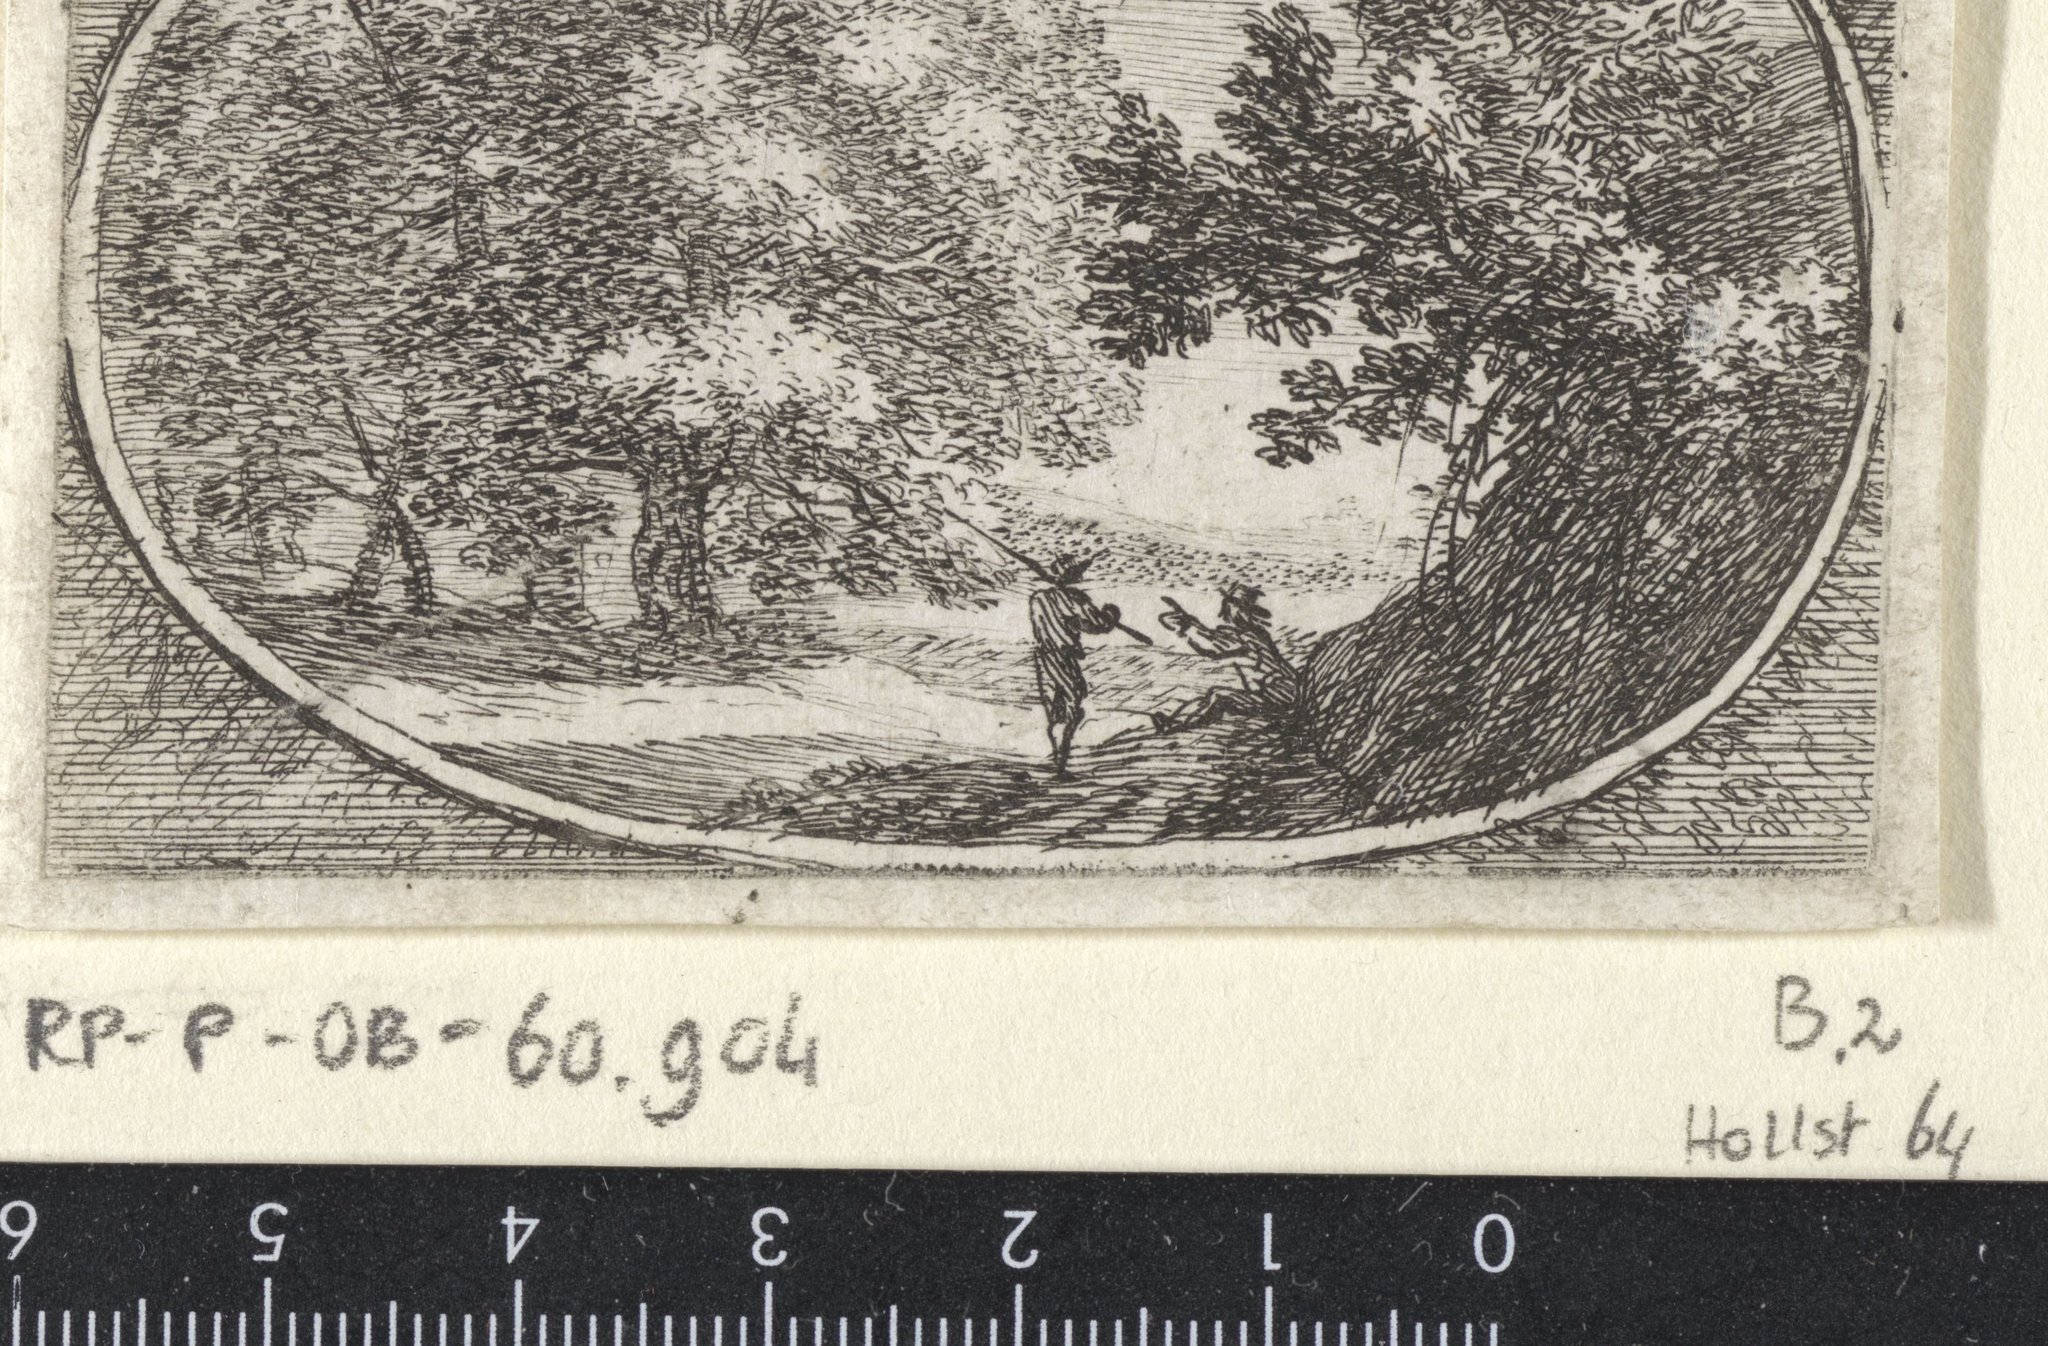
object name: print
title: Ovale fantasielandschappen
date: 1650-1655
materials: paper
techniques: etching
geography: paris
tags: landscapes, 'en route', traveller under way, sitting on an elevation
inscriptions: collector's mark: Lugt 240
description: In een ovale omlijsting zit een man onder een boom. Voor hem staat een tweede man.